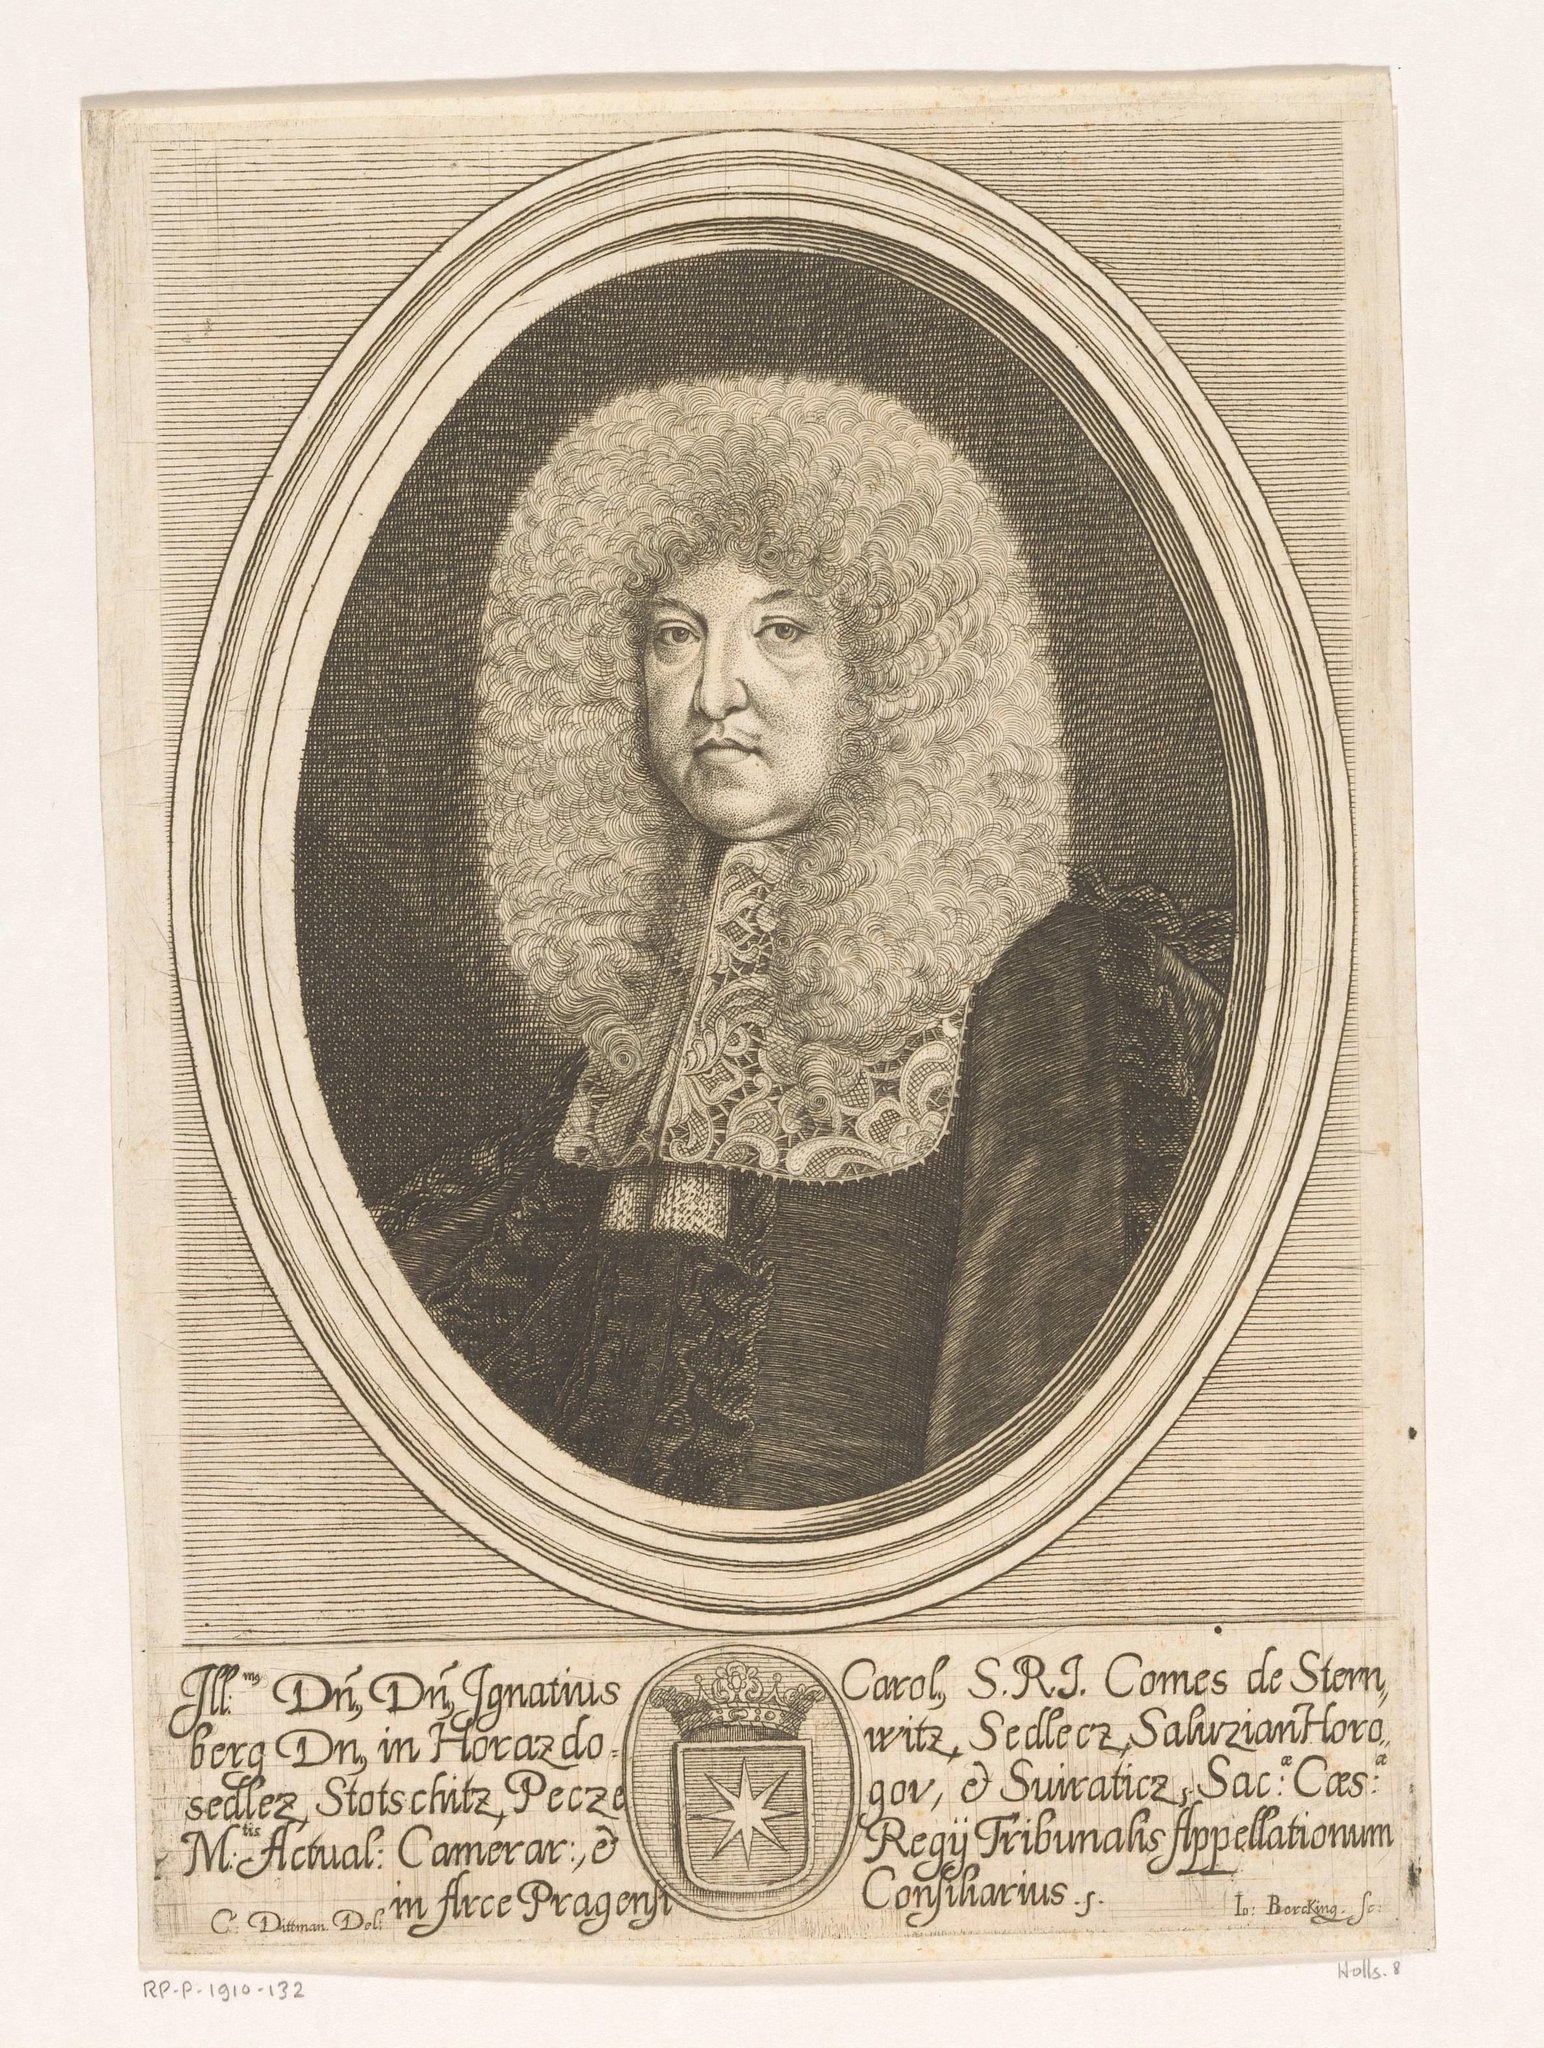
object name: print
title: Portret van Ignaz Carl, Reichsgraf von Sternberg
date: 1673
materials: paper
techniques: engraving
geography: prague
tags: historical persons, armorial bearing, heraldry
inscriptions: collector's mark: Lugt 2228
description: Prent ook gebruikt in: Weingarten, Johann Jacob von. Fürsten-Spiegel oder Monachia deß höchlöblichen Ertz-Hauses Oesterreich. 2 dln. Praag: [gedrukt door:] Johann Arnold von Dobroslawina, 1673.